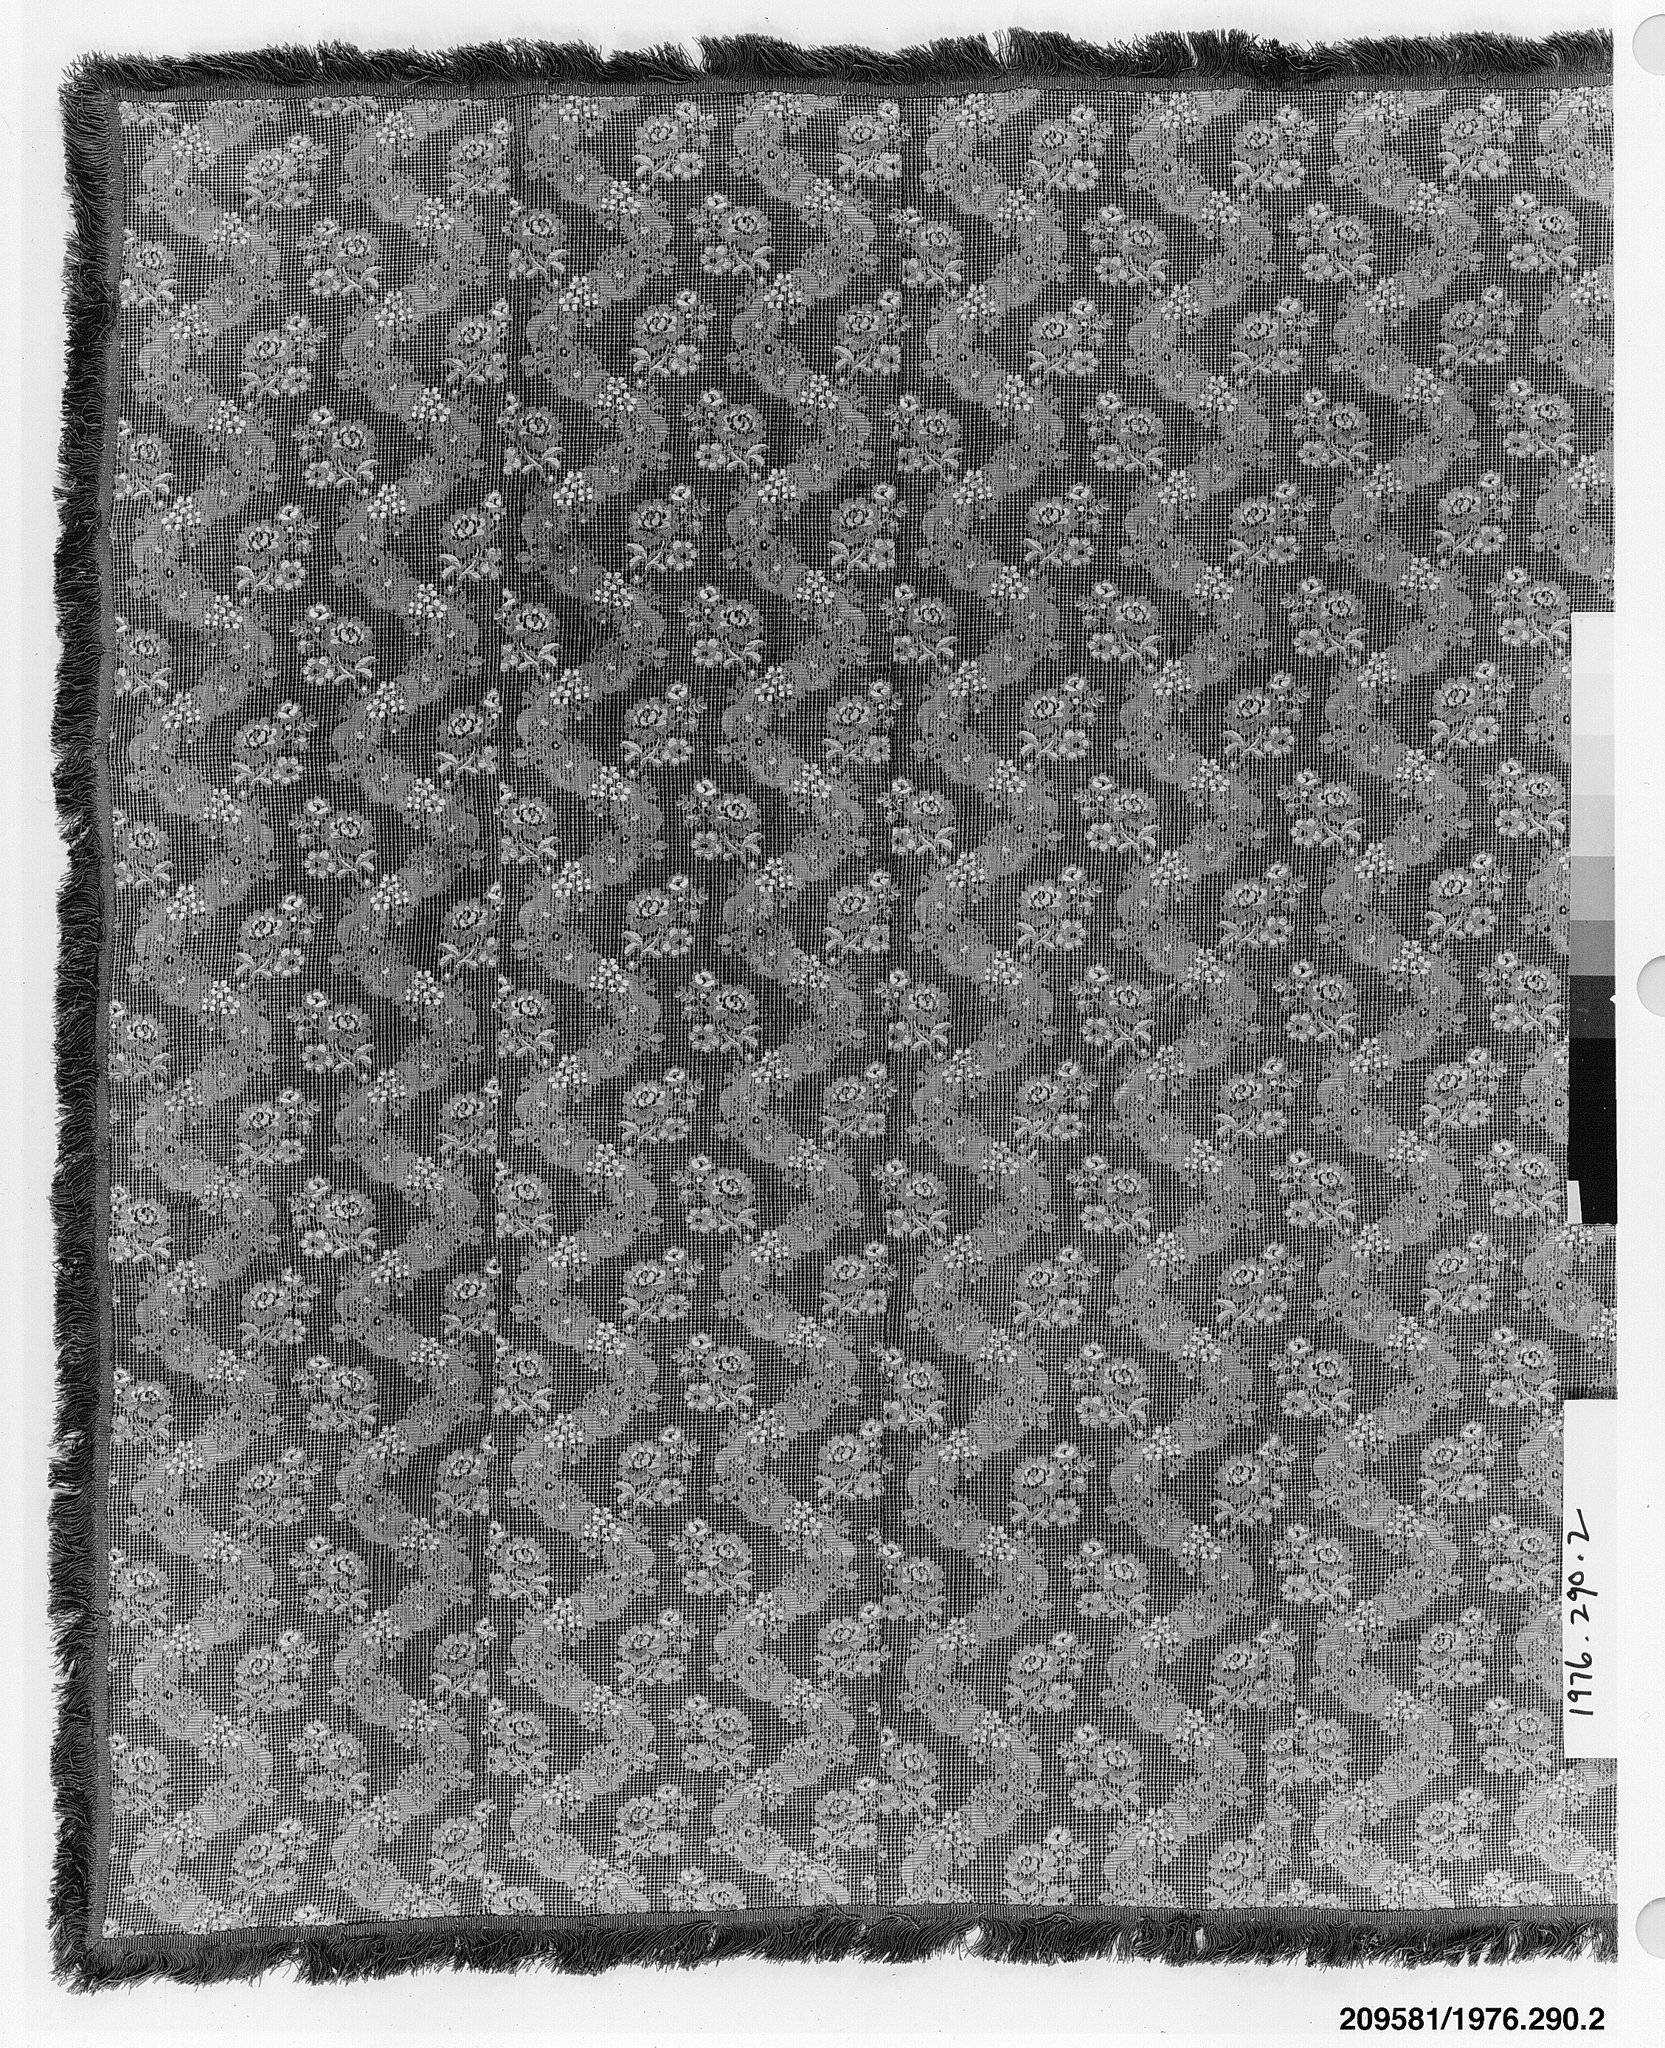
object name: panel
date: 1775-1780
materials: silk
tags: flowers